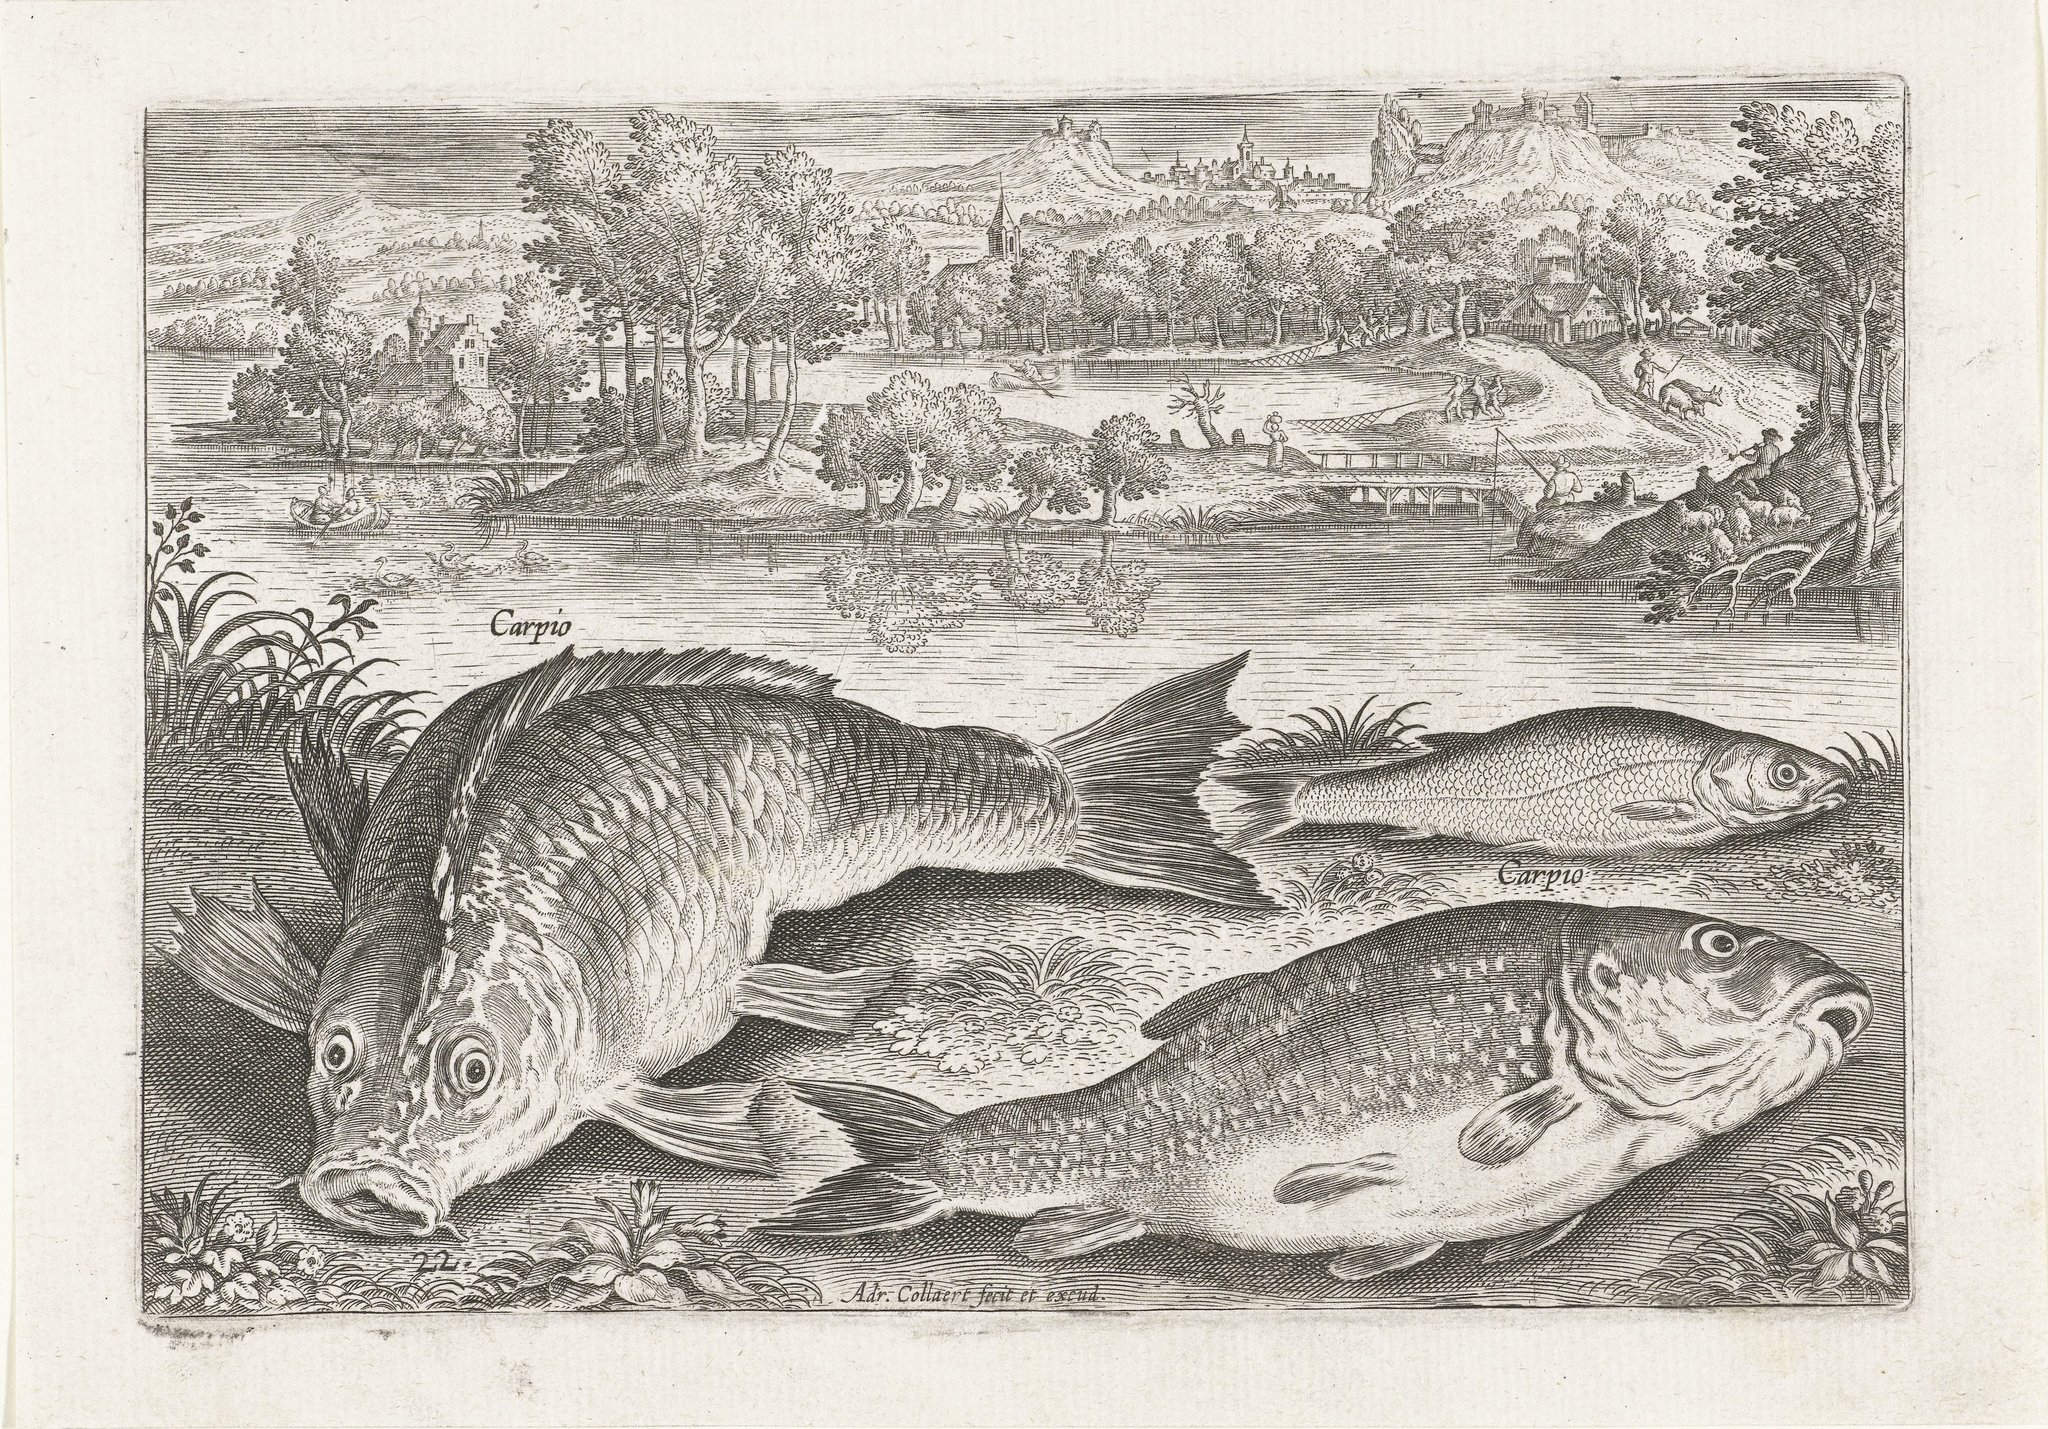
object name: print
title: Piscivm vivae icones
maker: adriaen collaert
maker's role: draughtsman, print maker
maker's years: 1560-1618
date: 1598-1618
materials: paper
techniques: engraving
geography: antwerp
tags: river, bony fishes: carp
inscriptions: collector's mark: Lugt 2228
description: Drie soorten karpers liggen samen op de oever van een rivier. Op de achtergrond de rivier. De prent maakt deel uit van een serie met vissen als onderwerp.